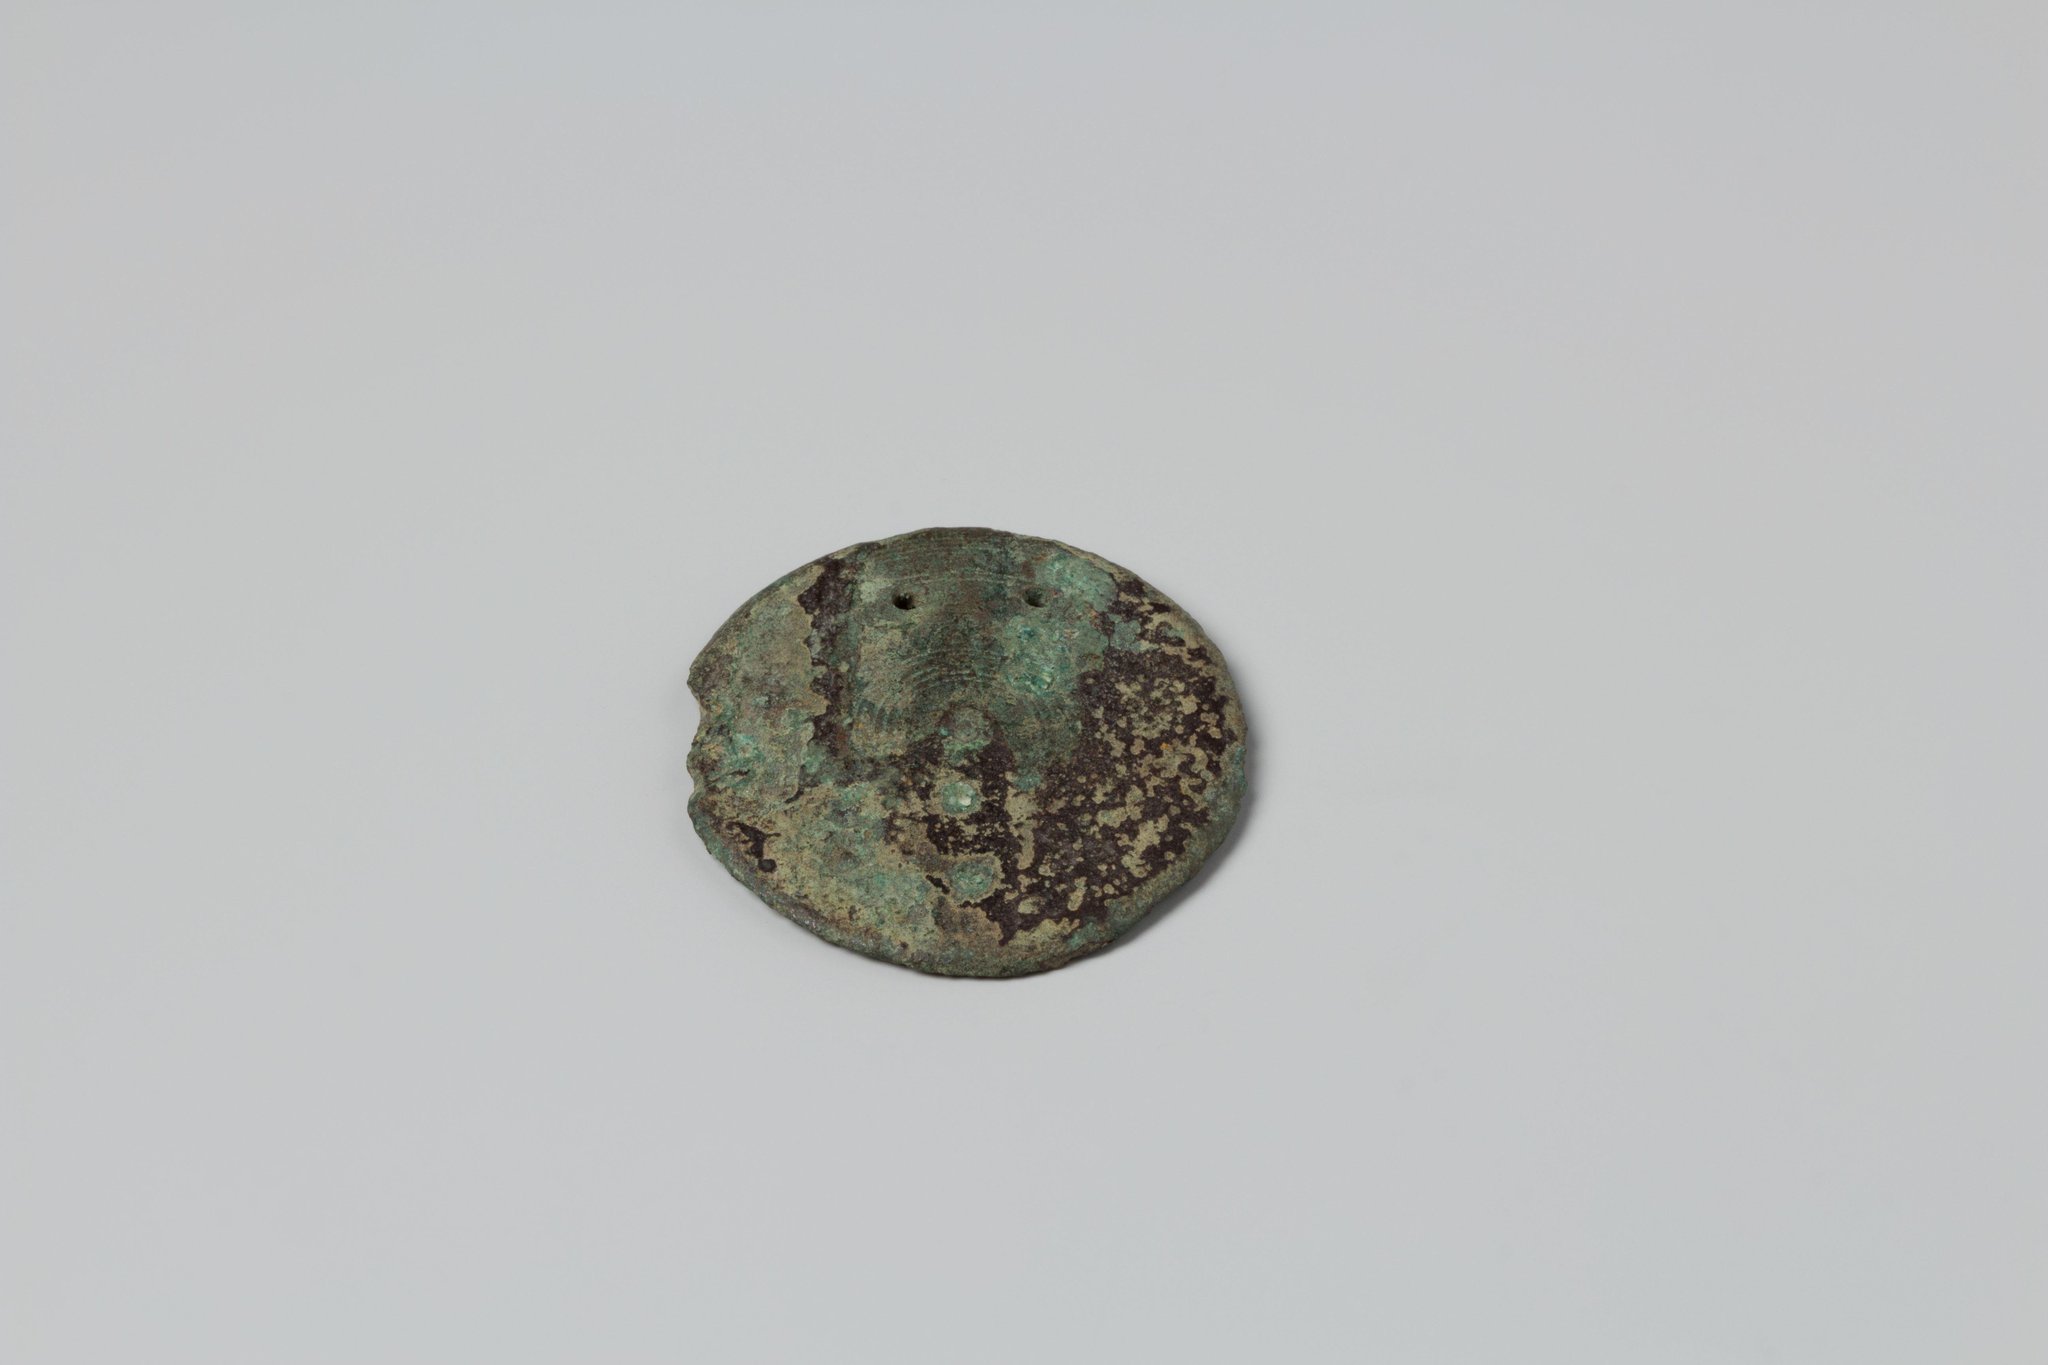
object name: lid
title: Deksel van een sluitgewicht uit het wrak van de Oost-Indiëvaarder Hollandia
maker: Anonymous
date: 1700-1743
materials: copper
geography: netherlands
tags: verenigde oostindische compagnie, hollandia (schip), annet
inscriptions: mark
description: Deksel van een sluitgewicht uit het wrak van de Oostindiëvaarder Hollandia.